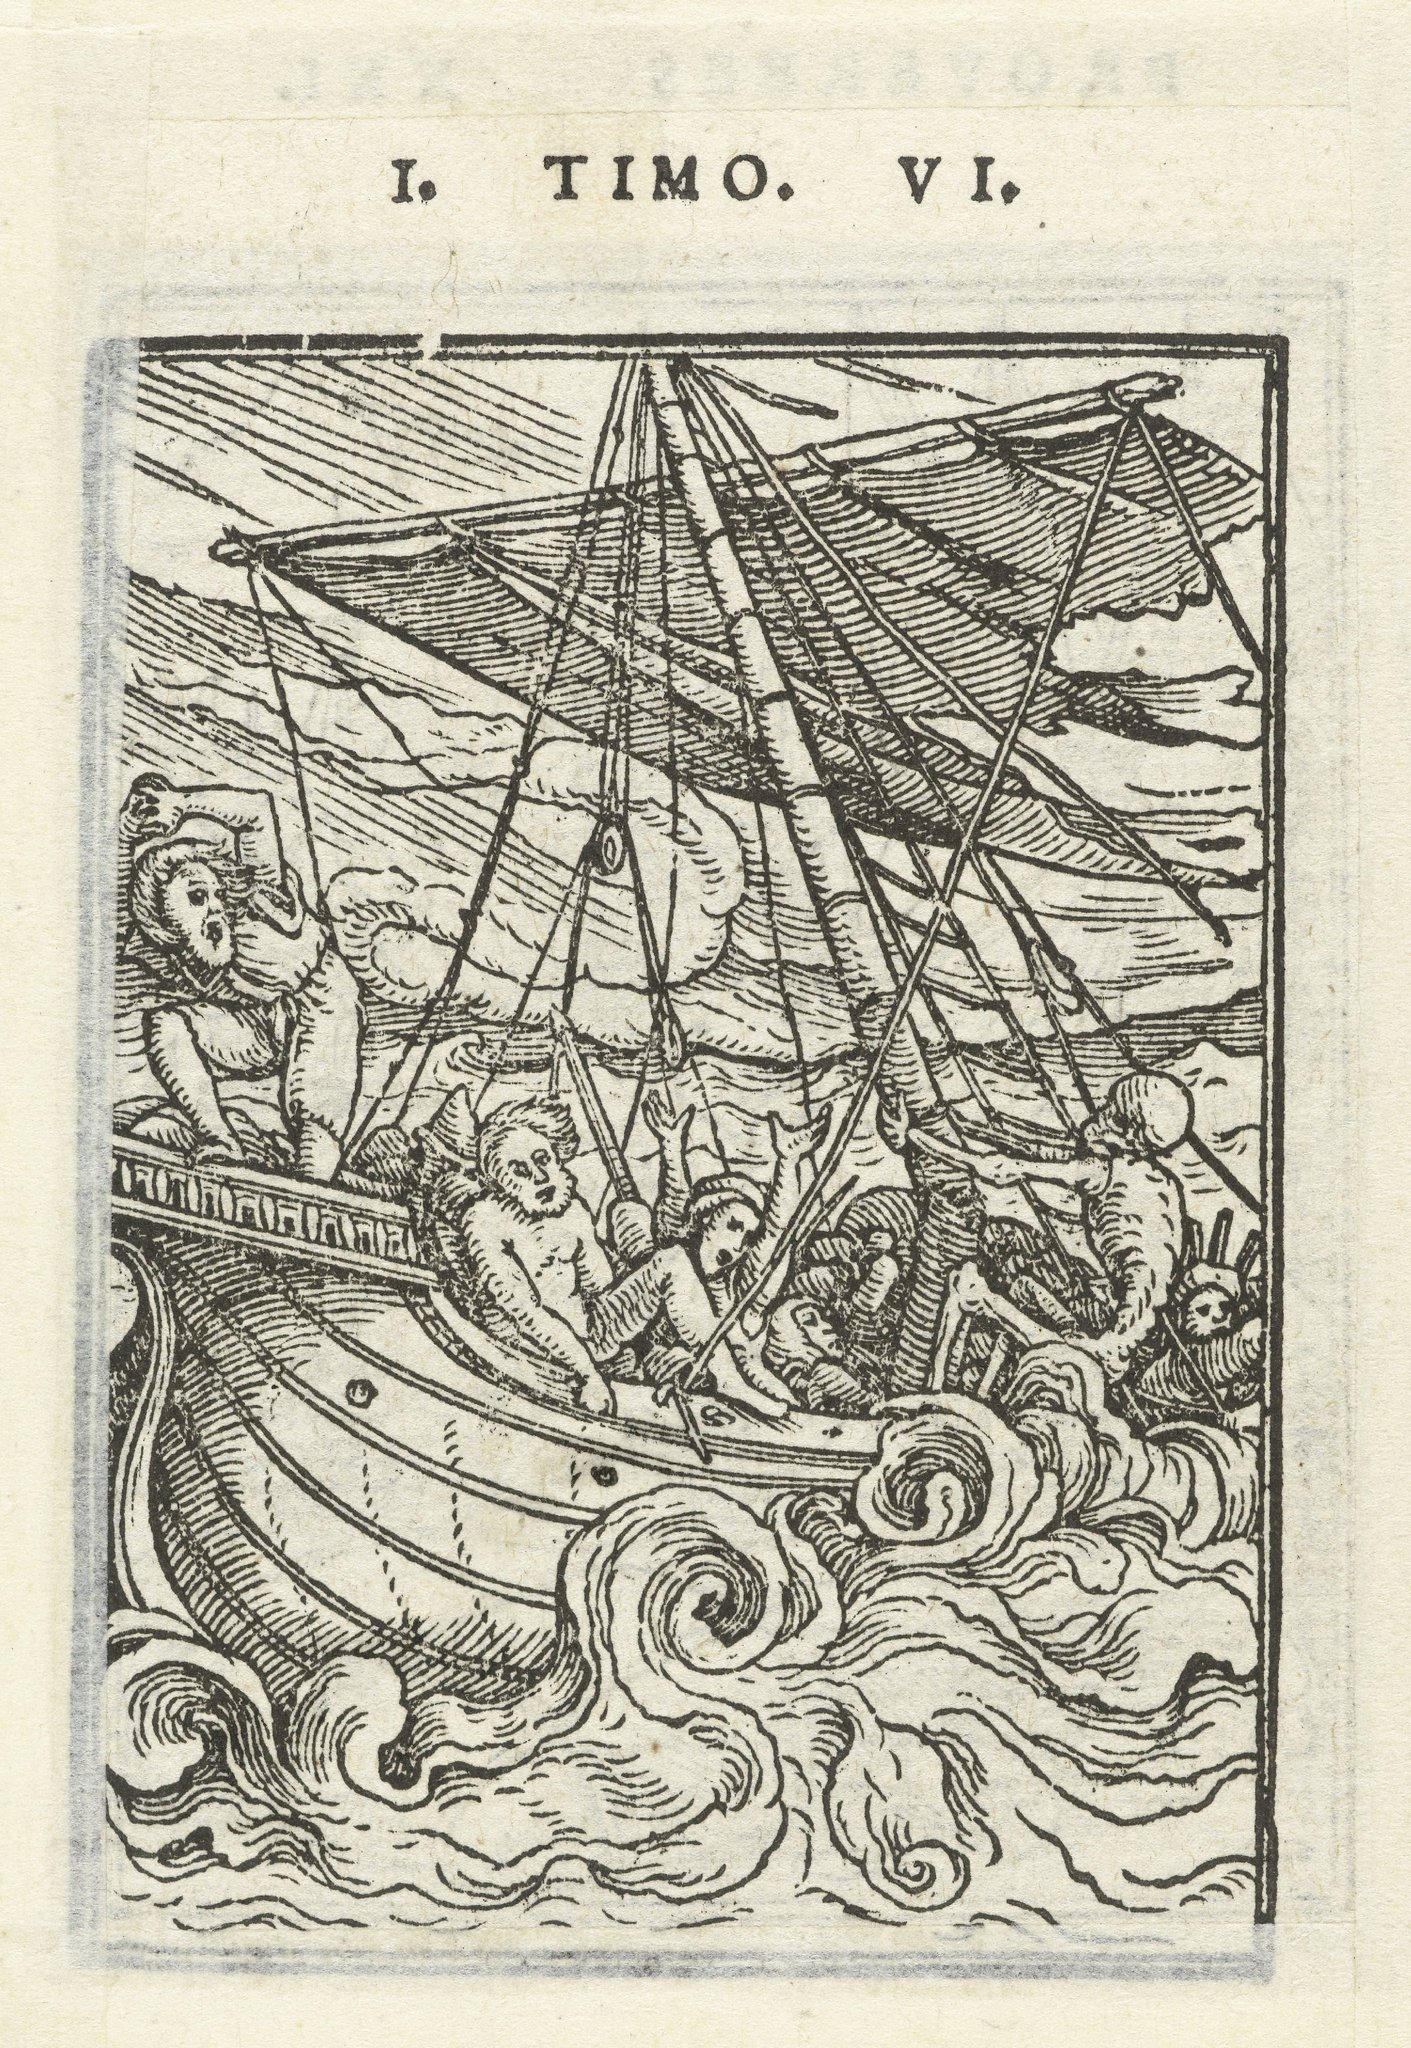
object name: book illustration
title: Schipper en de Dood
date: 1524-1526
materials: paper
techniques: woodcut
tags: shipwreck, dance of death; death together with one or more human beings, seaman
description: De houtblokken werden voor 1526 vervaardigd door Hans Lützelburg en pas in 1538 voor het eerst gebruikt als boekillustraties in: Les simulachres & historiees faces de la mort avtant elegamment pourtraictes que artificiellement imaginées... a Lyon, Soubsz l'escu de Coloigne, MDXXXVIII, (M. en G. Trechsel, voor F. Frellon in Lyon), 1538. Later verschenen nog andere uitgaven.